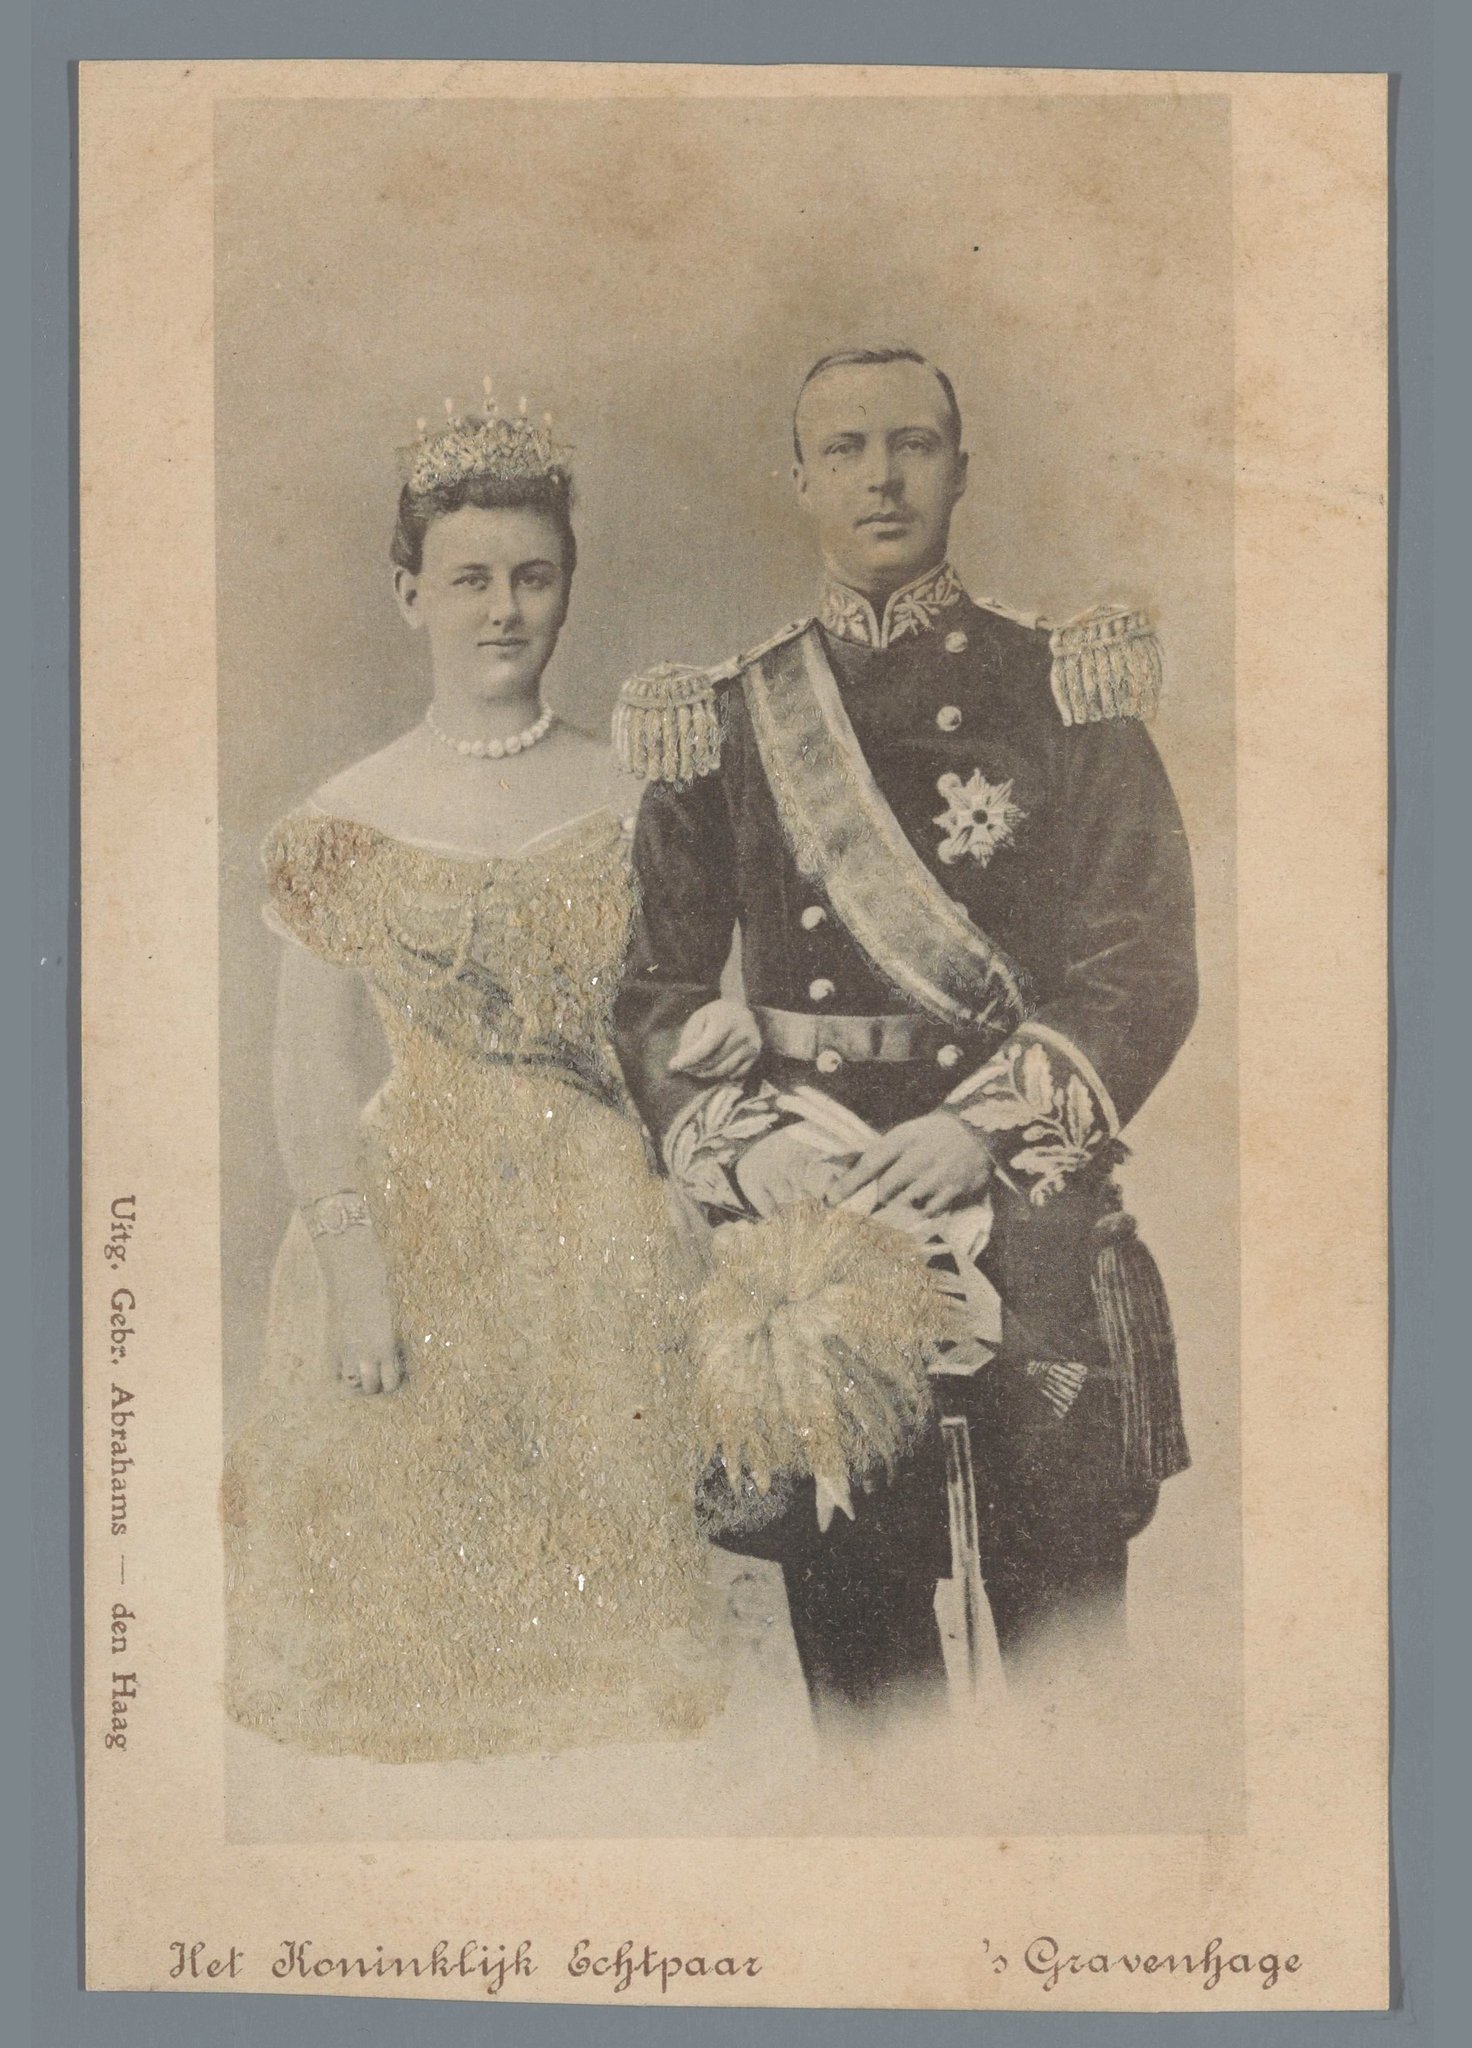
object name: photomechanical print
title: Het koninklijk echtpaar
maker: Anonymous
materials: cardboard, glitter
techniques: photograph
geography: the hague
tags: the hague, print maker, wilhelmina of the netherlands, hendrik (prins der nederlanden), prince, queen